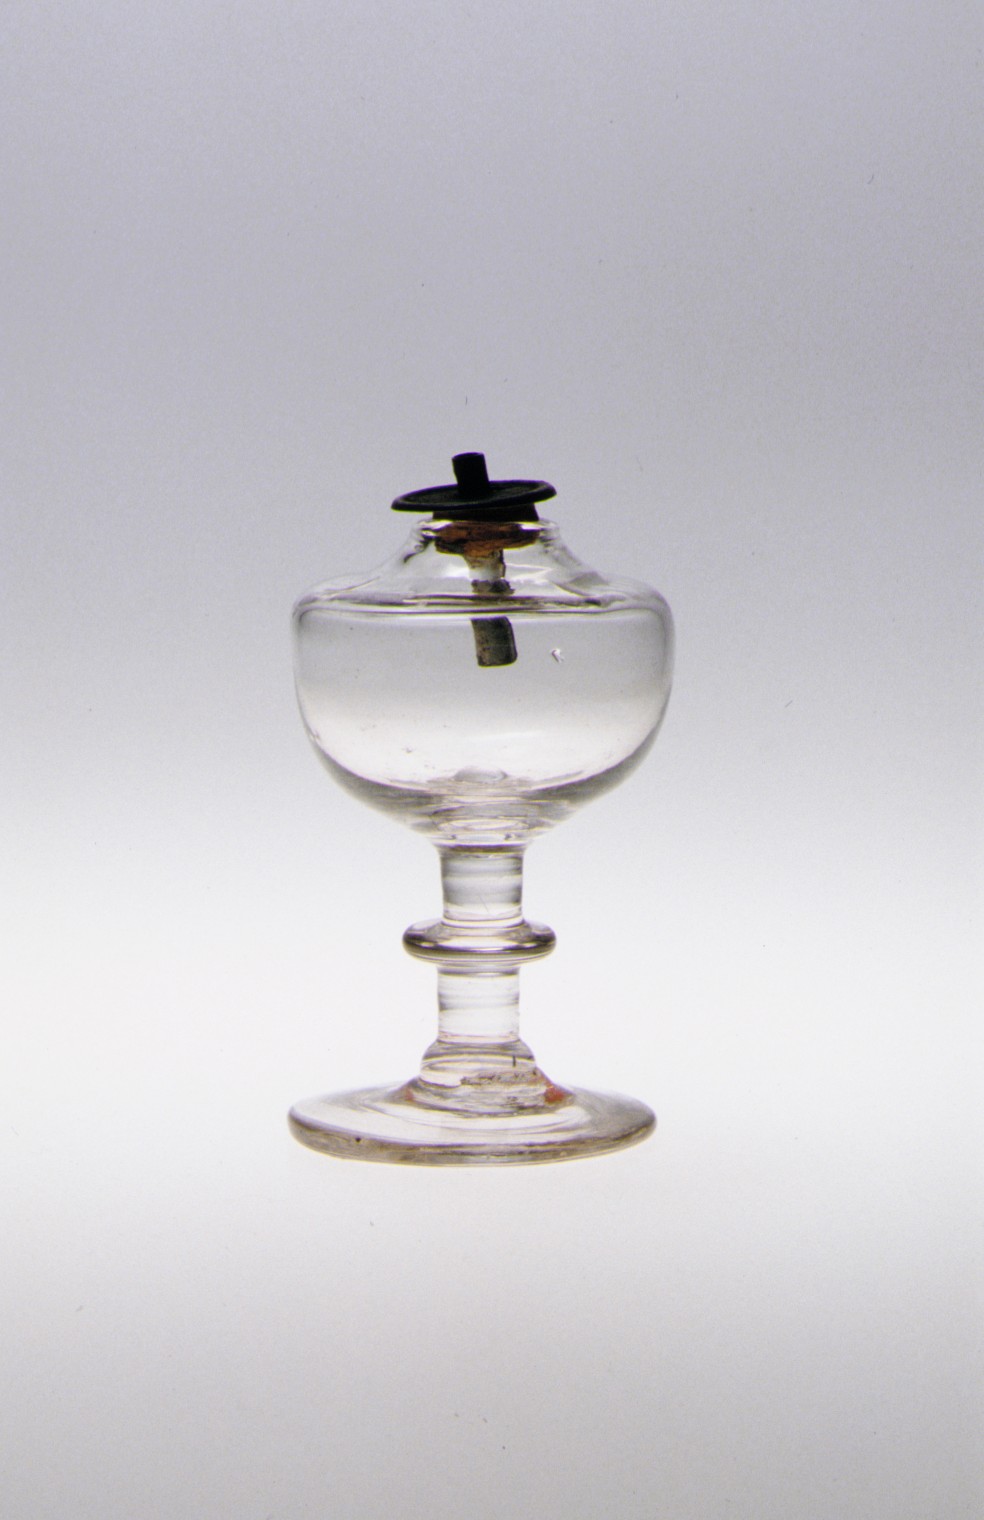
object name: whale oil lamp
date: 1825-1840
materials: glass, lead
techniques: glassblowing, pressed